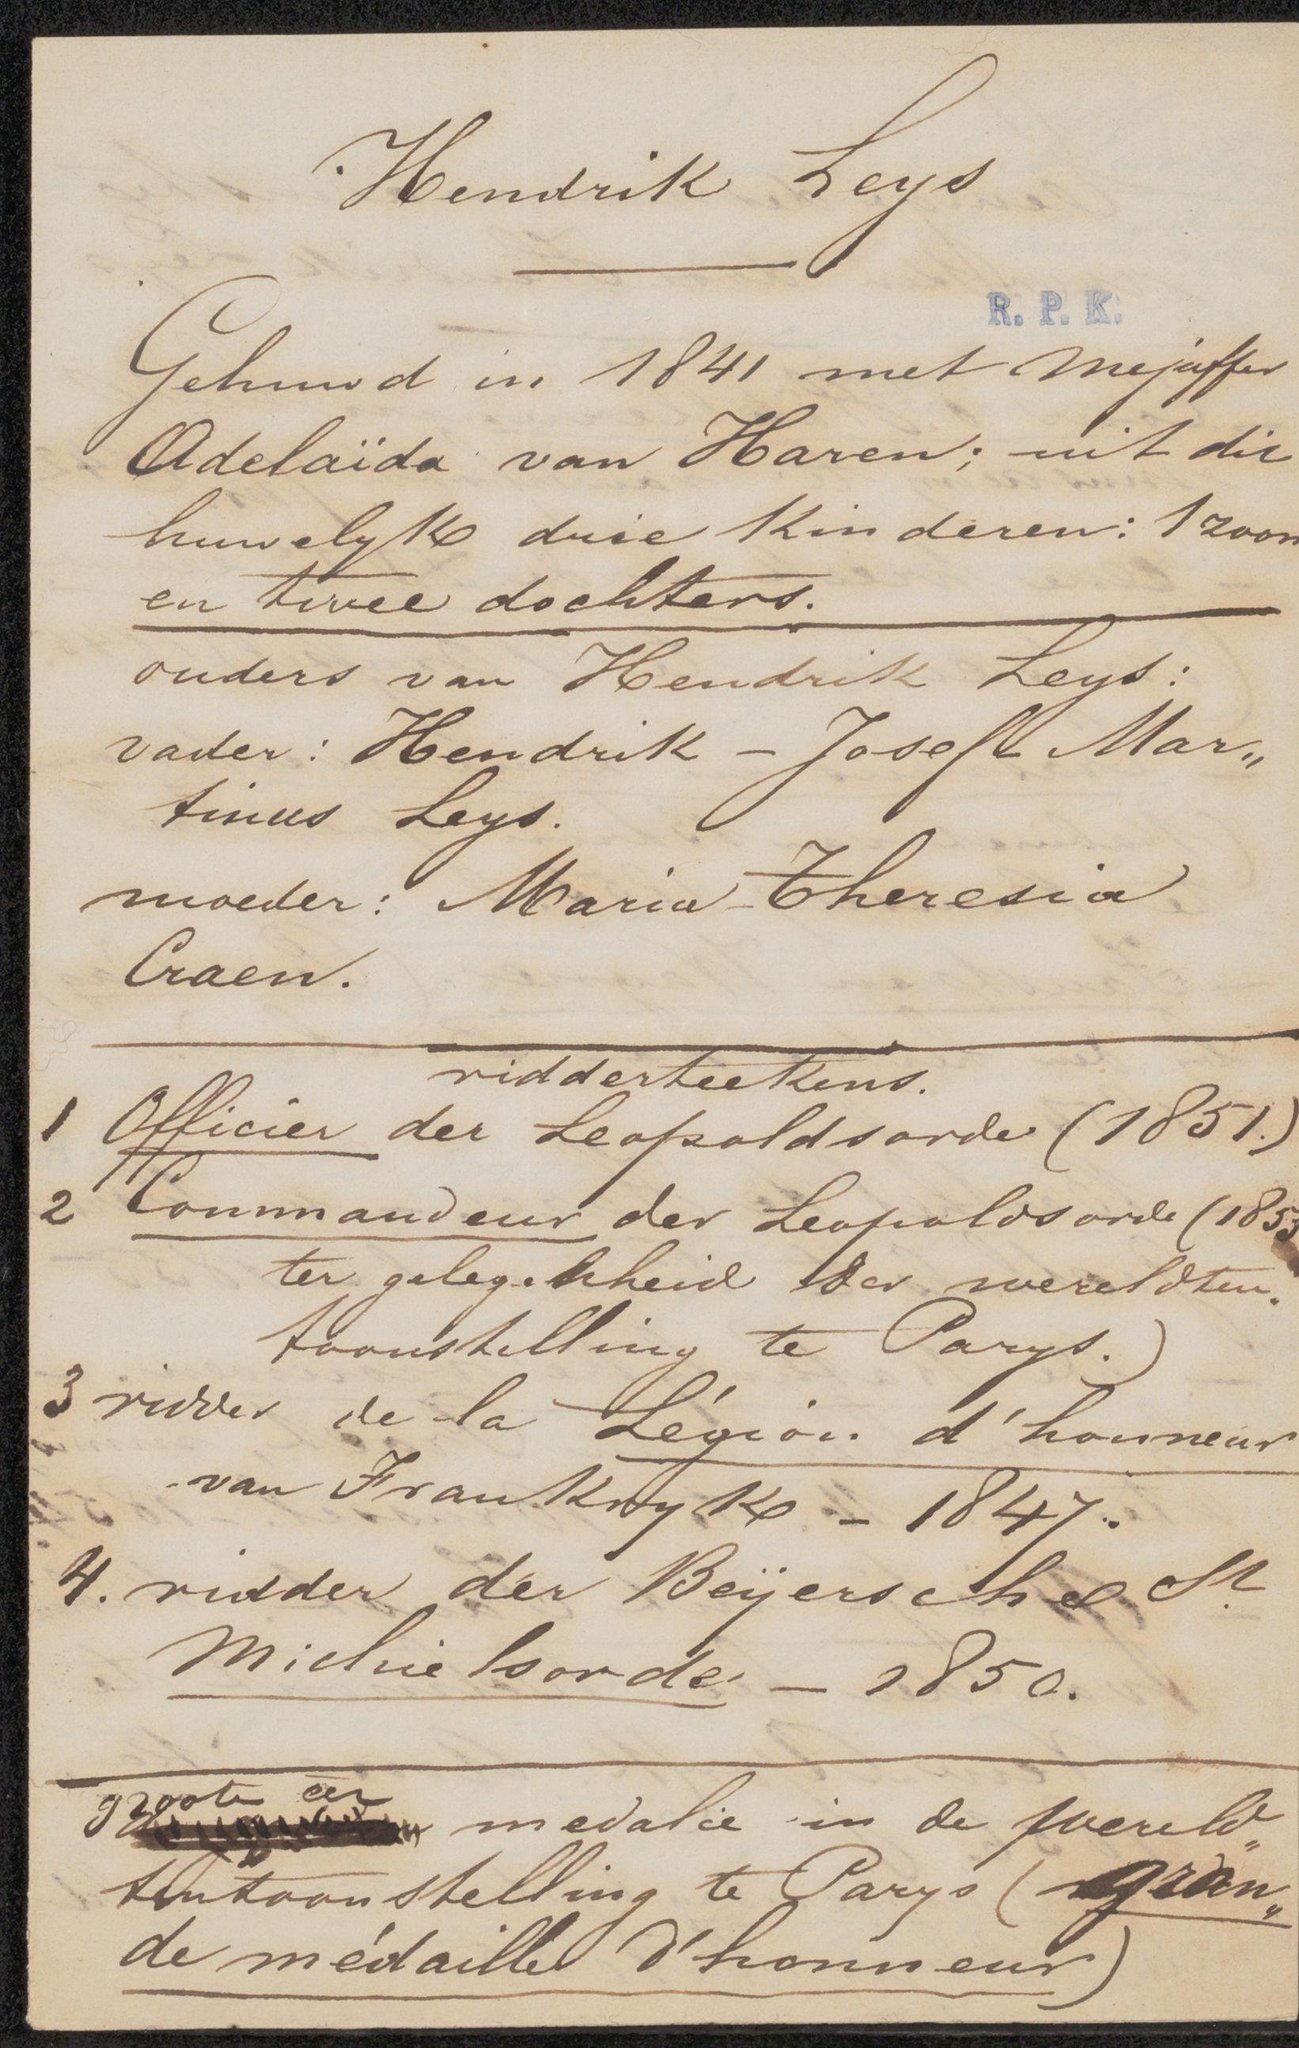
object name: aantekening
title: Aantekening betreffende baron Henri Leys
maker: Anonymous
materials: ink, paper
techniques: pen, writing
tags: antwerp, painter, print maker, draughtsman, henri leys (baron), distribution of awards ~ art contest, family life, exhibition ~ art, art collecting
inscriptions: collector's mark: Lugt 2233